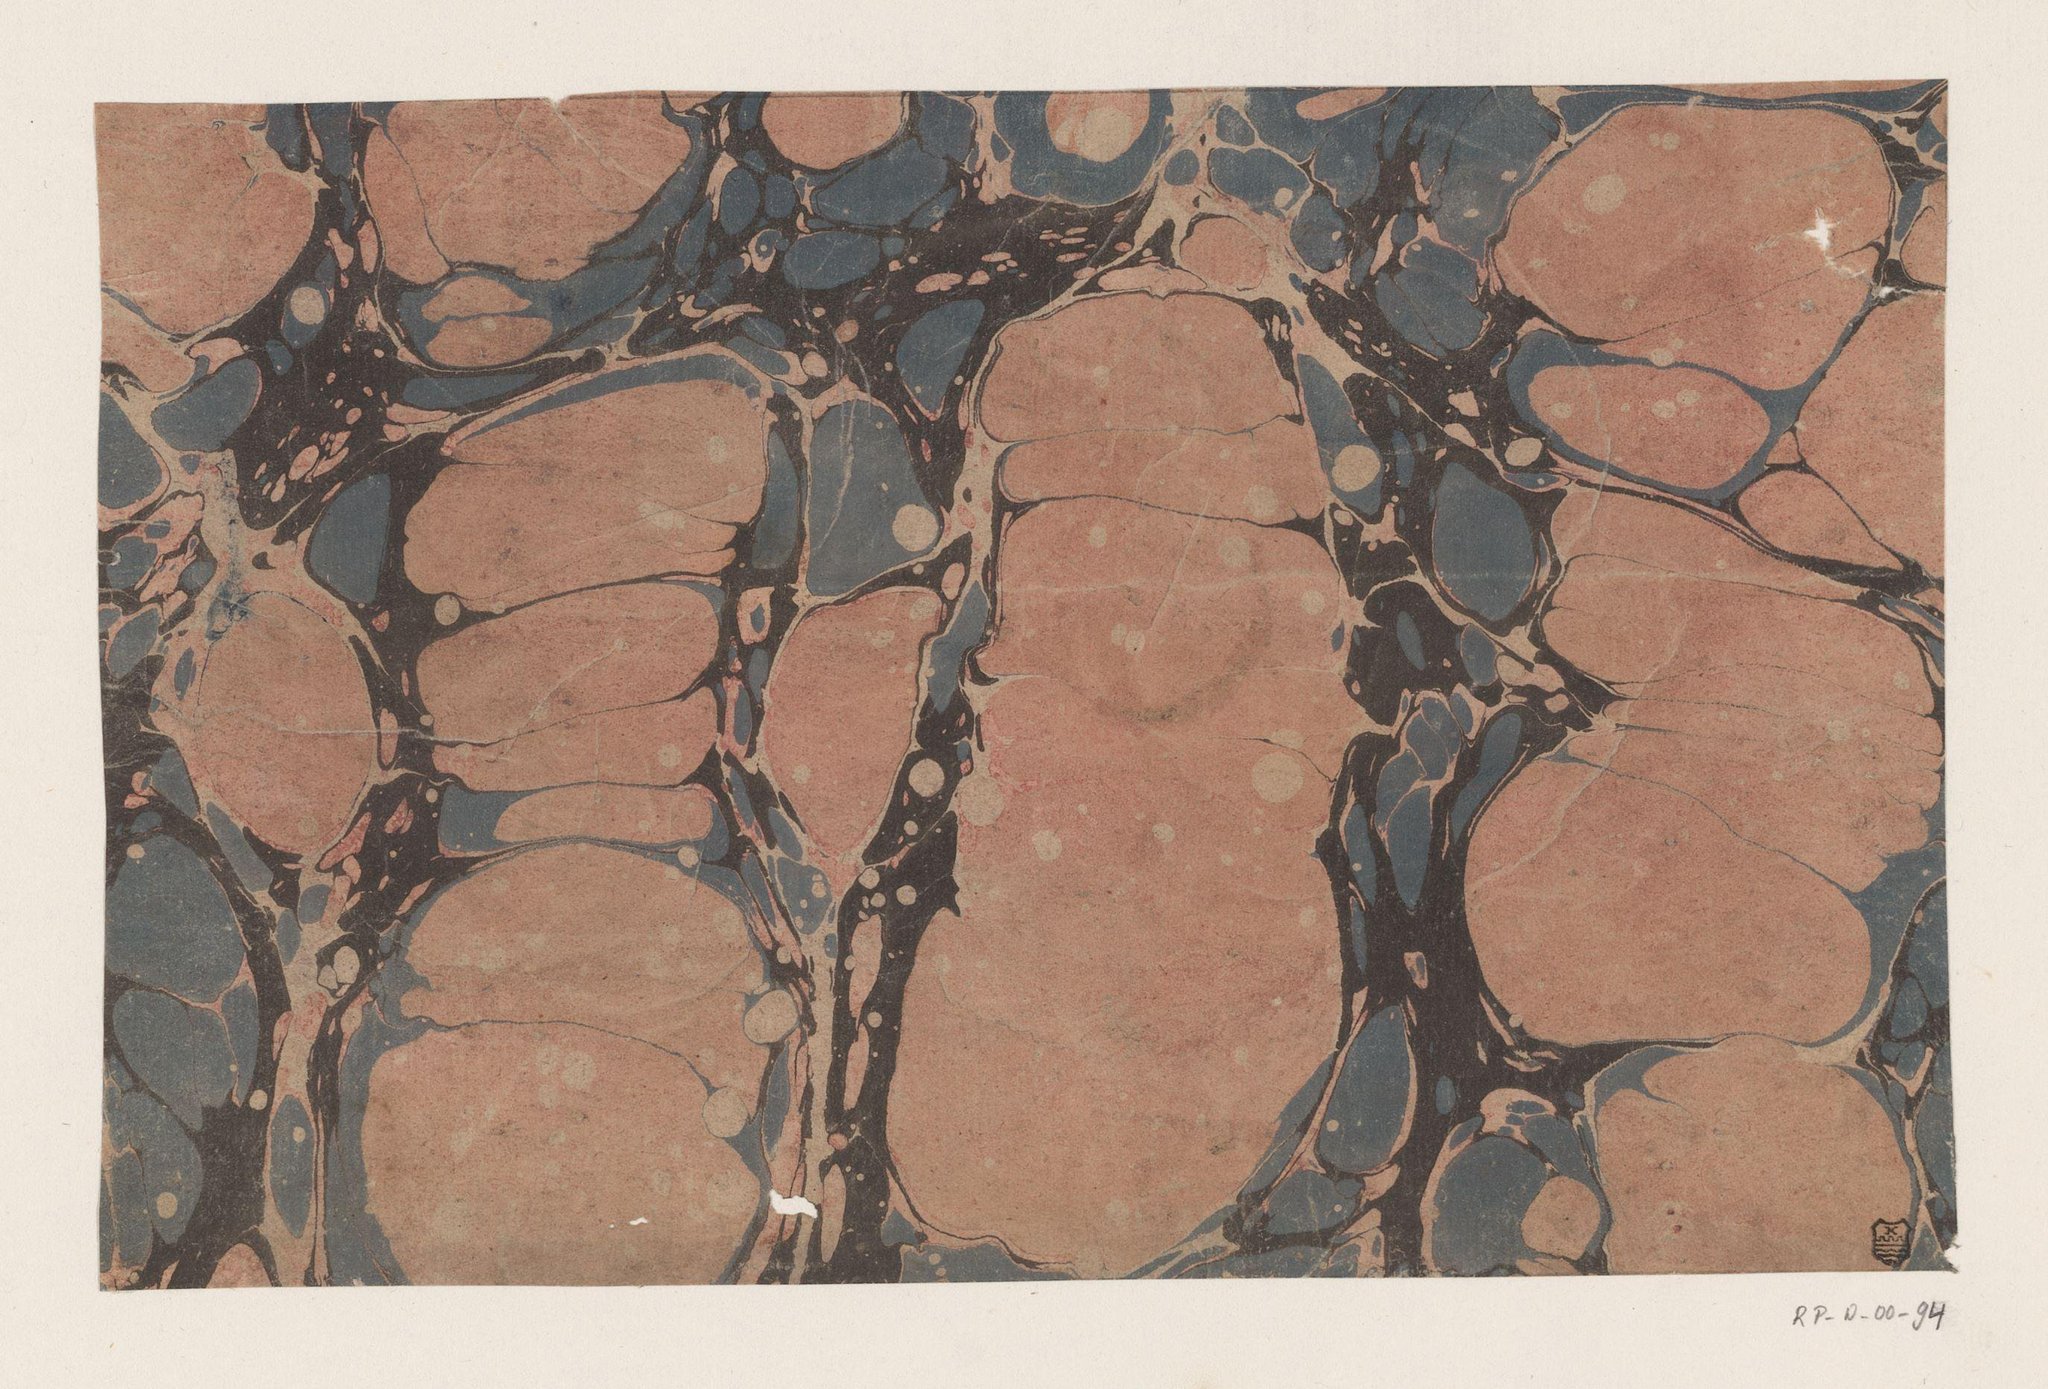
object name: marbled paper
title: Kiezelmarmer in roze, blauw en zwart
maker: Anonymous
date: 1700-1850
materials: paint, paper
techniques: marbling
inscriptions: collector's mark: Lugt 2760